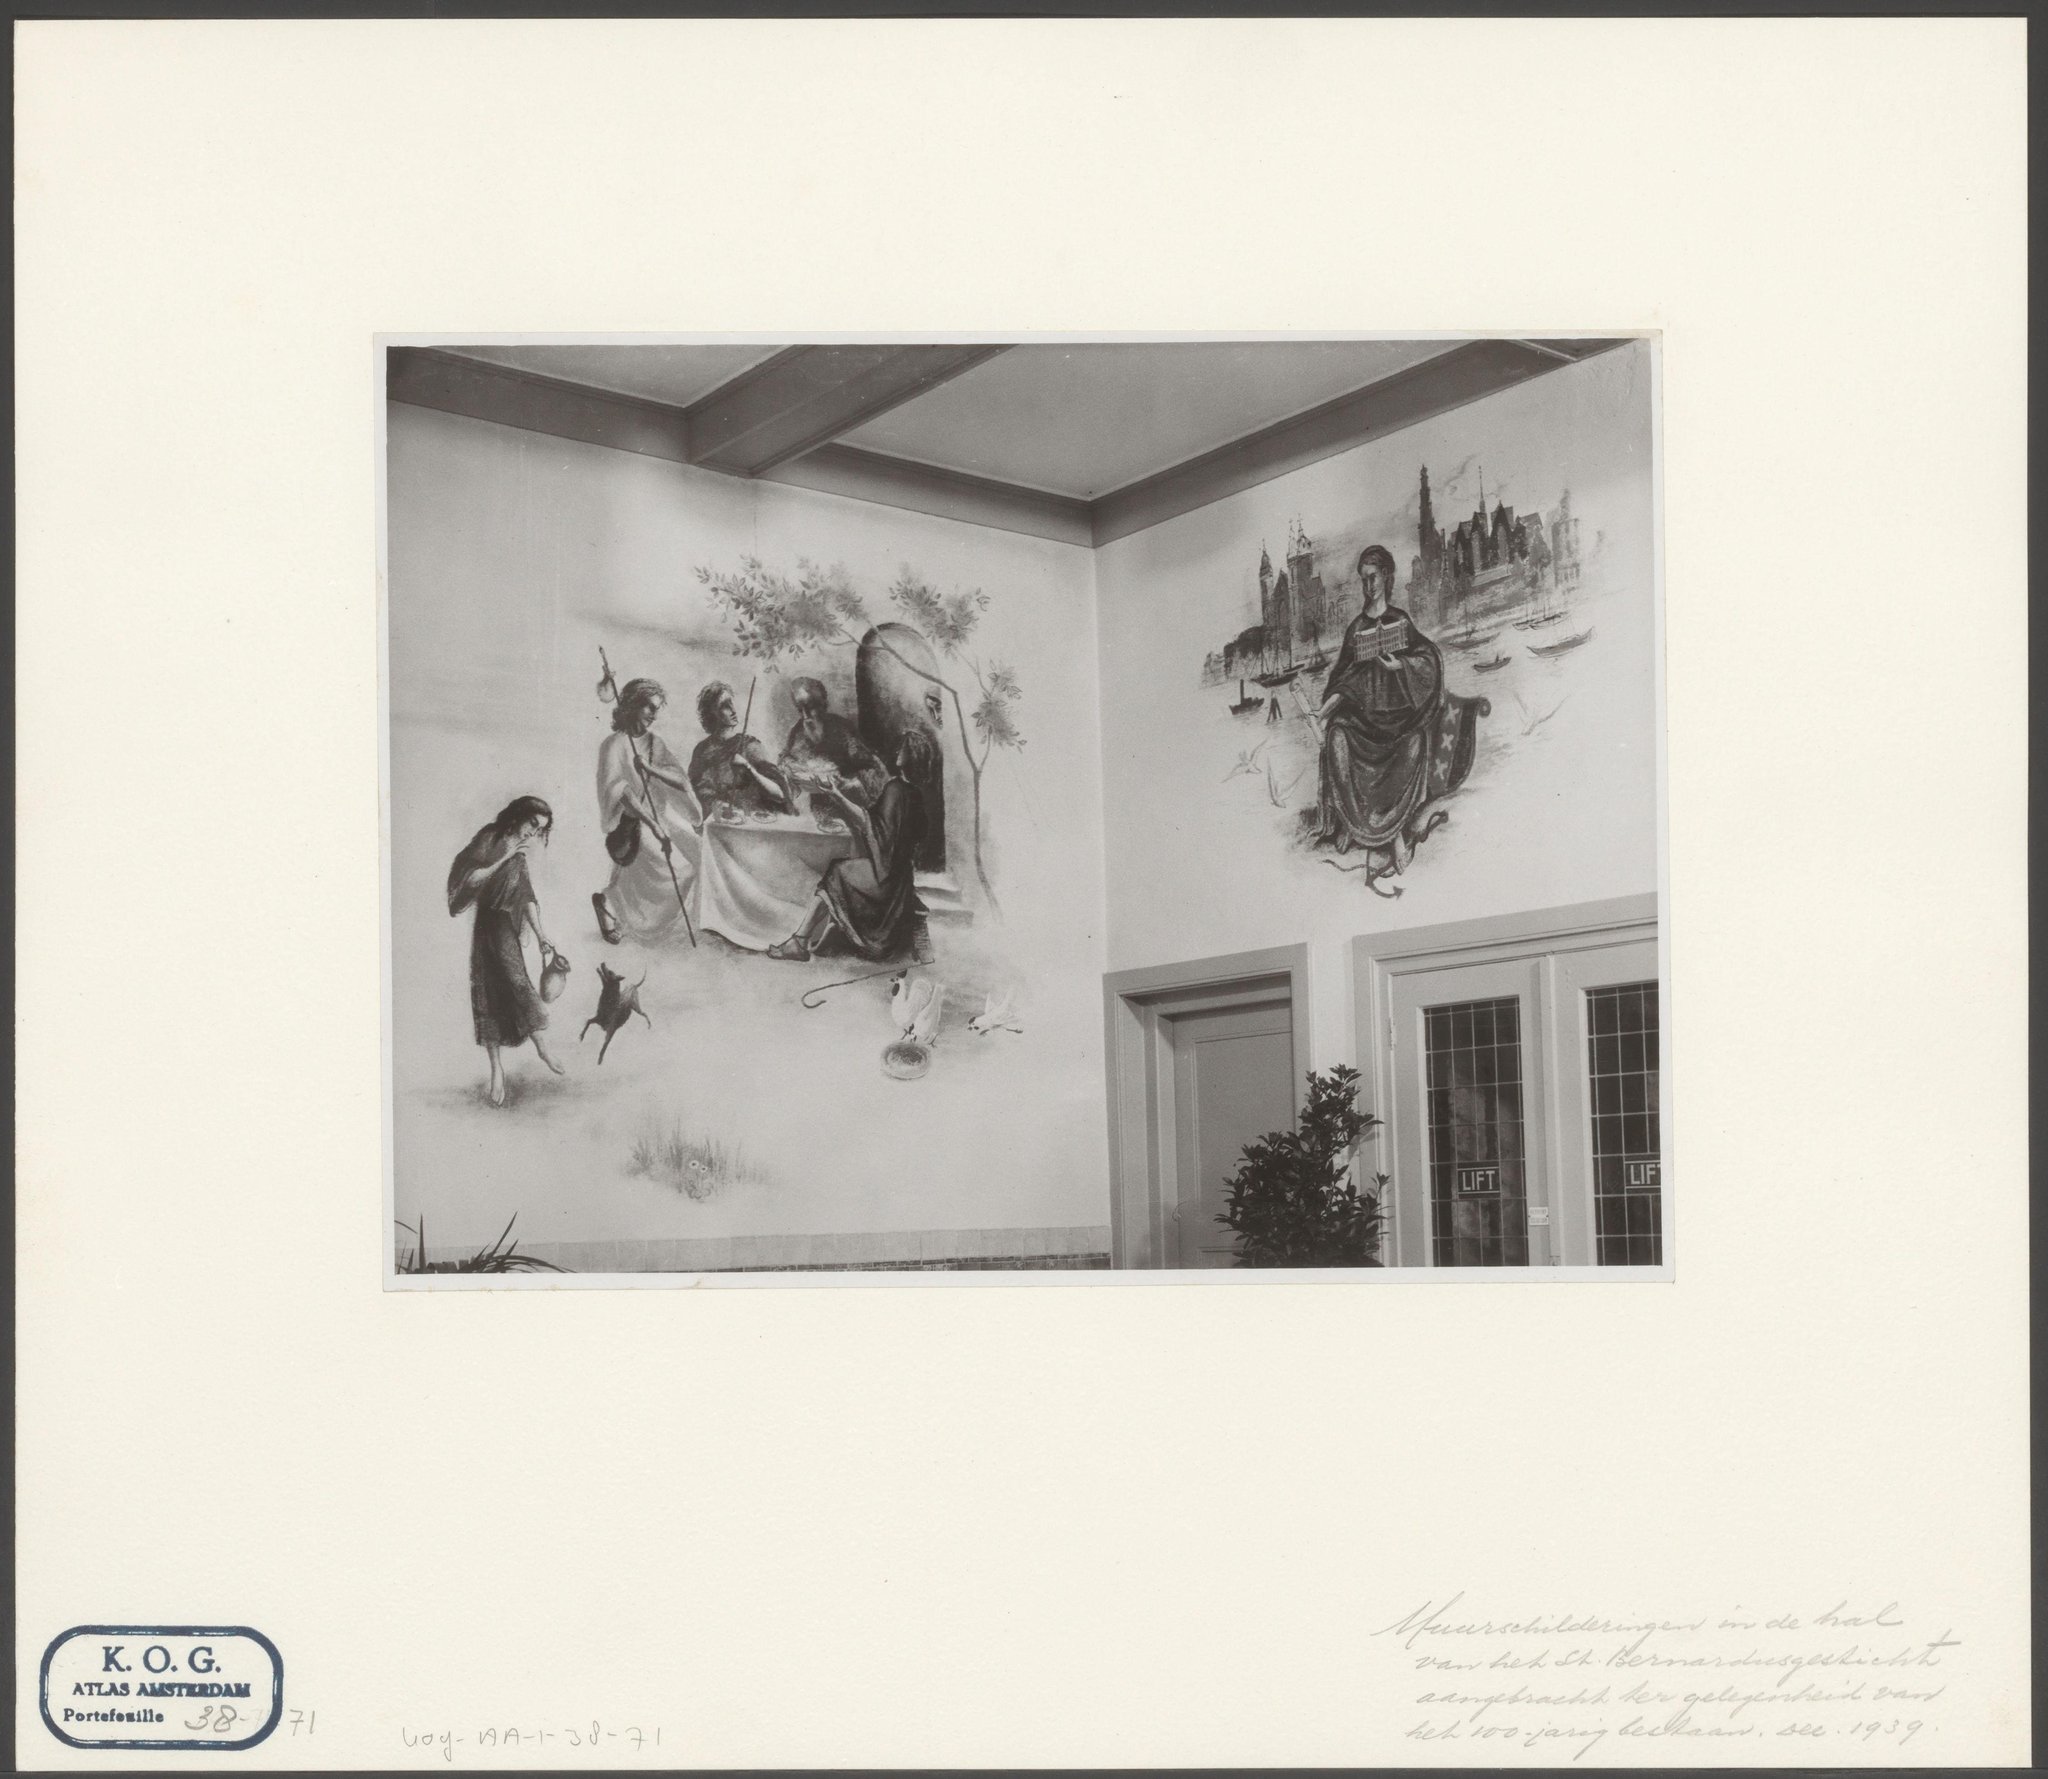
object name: photograph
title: Muurschildering in de hal van het Sint-Bernardusgesticht te Amsterdam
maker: Anonymous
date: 1912-1939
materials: paper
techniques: gelatin silver print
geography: amsterdam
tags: personification of a city, town-patron(ess), the visit of the three angels (three men) ~ story of abraham (genesis 18), picture, painting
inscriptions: collector's mark: Lugt 1641b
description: Onderwerpsrubriek binnen de Atlas Amsterdam: Armwezen en liefdadige instellingen: II. Kerkelijke inrichtingen: Inrichtingen der Roomsch-Katholieken.